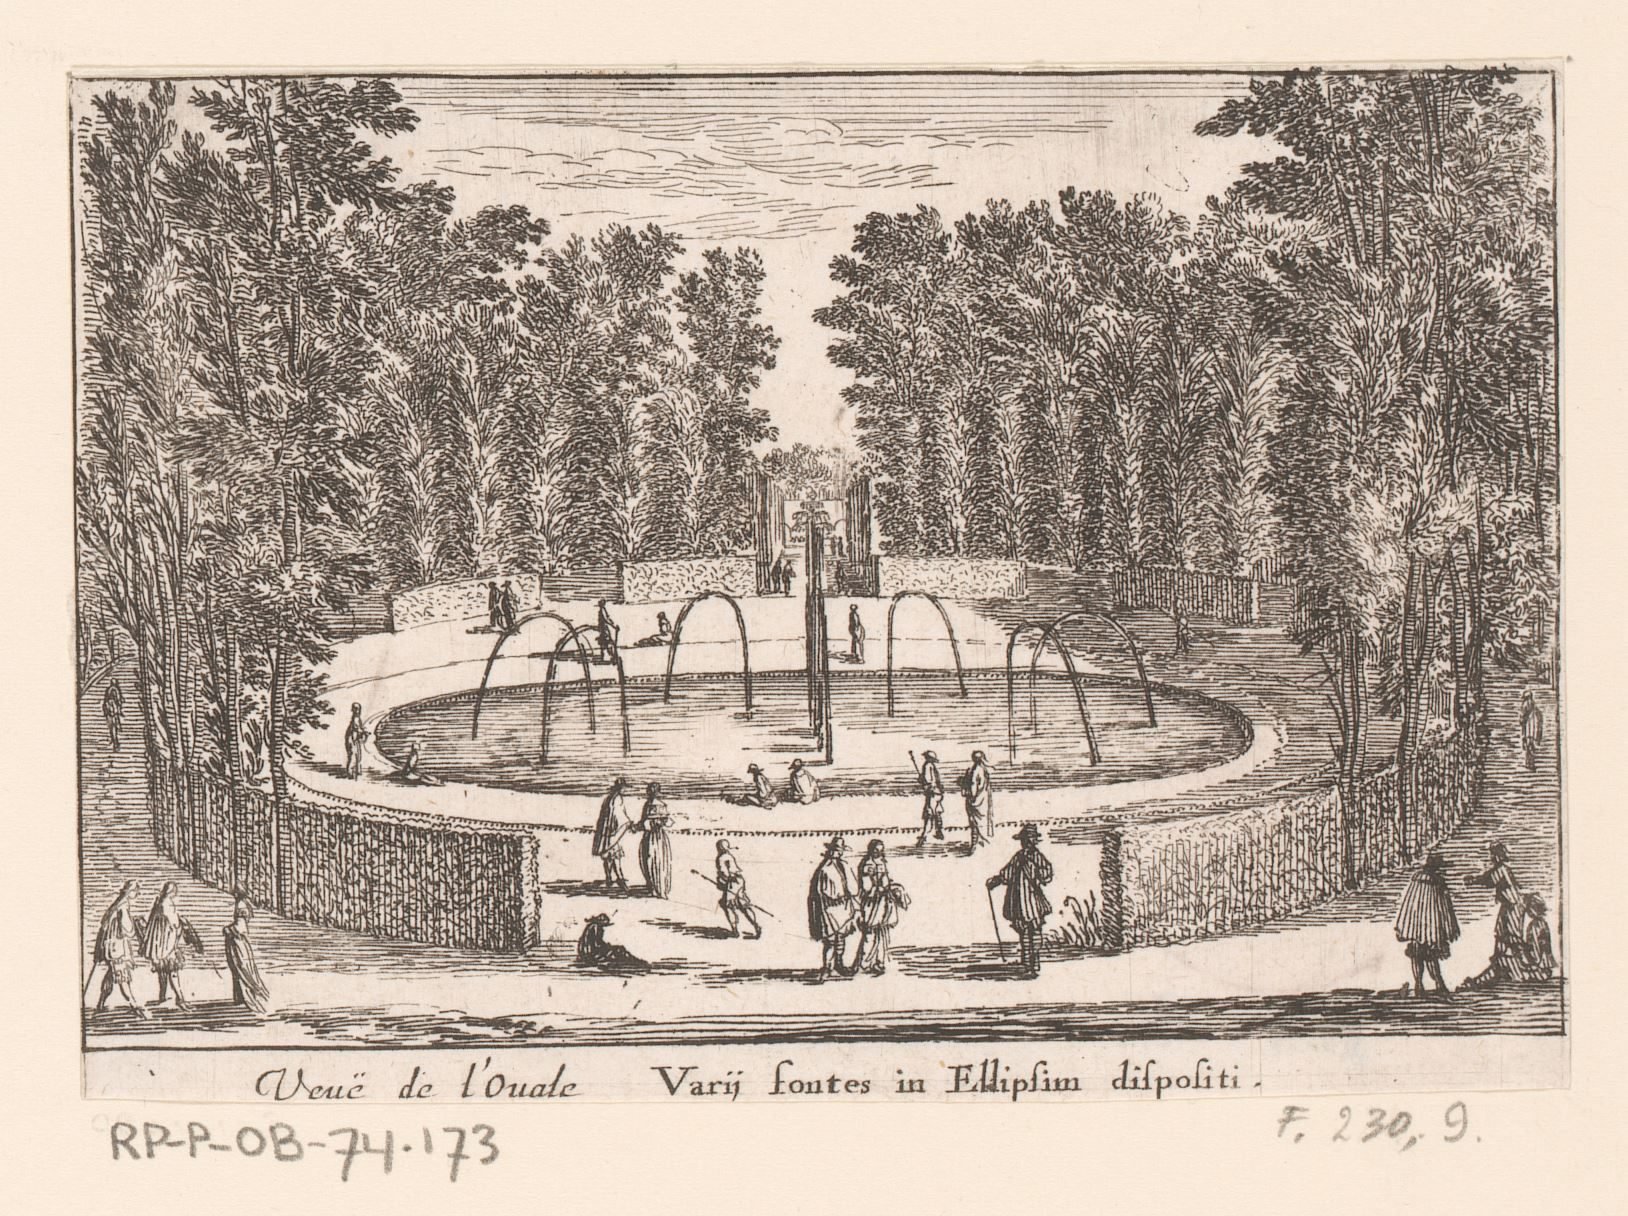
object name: print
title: Veue de l'Ovale, Varij fontes in Ellipsim dispositi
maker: israël silvestre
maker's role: draughtsman, print maker, publisher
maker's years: 1621-1691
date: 1631-1691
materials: paper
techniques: etching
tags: garden fountain, french or architectonic garden; formal garden, paris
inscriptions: collector's mark: Lugt 240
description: Prent maakt deel uit van een ongenummerde serie van negen prenten.